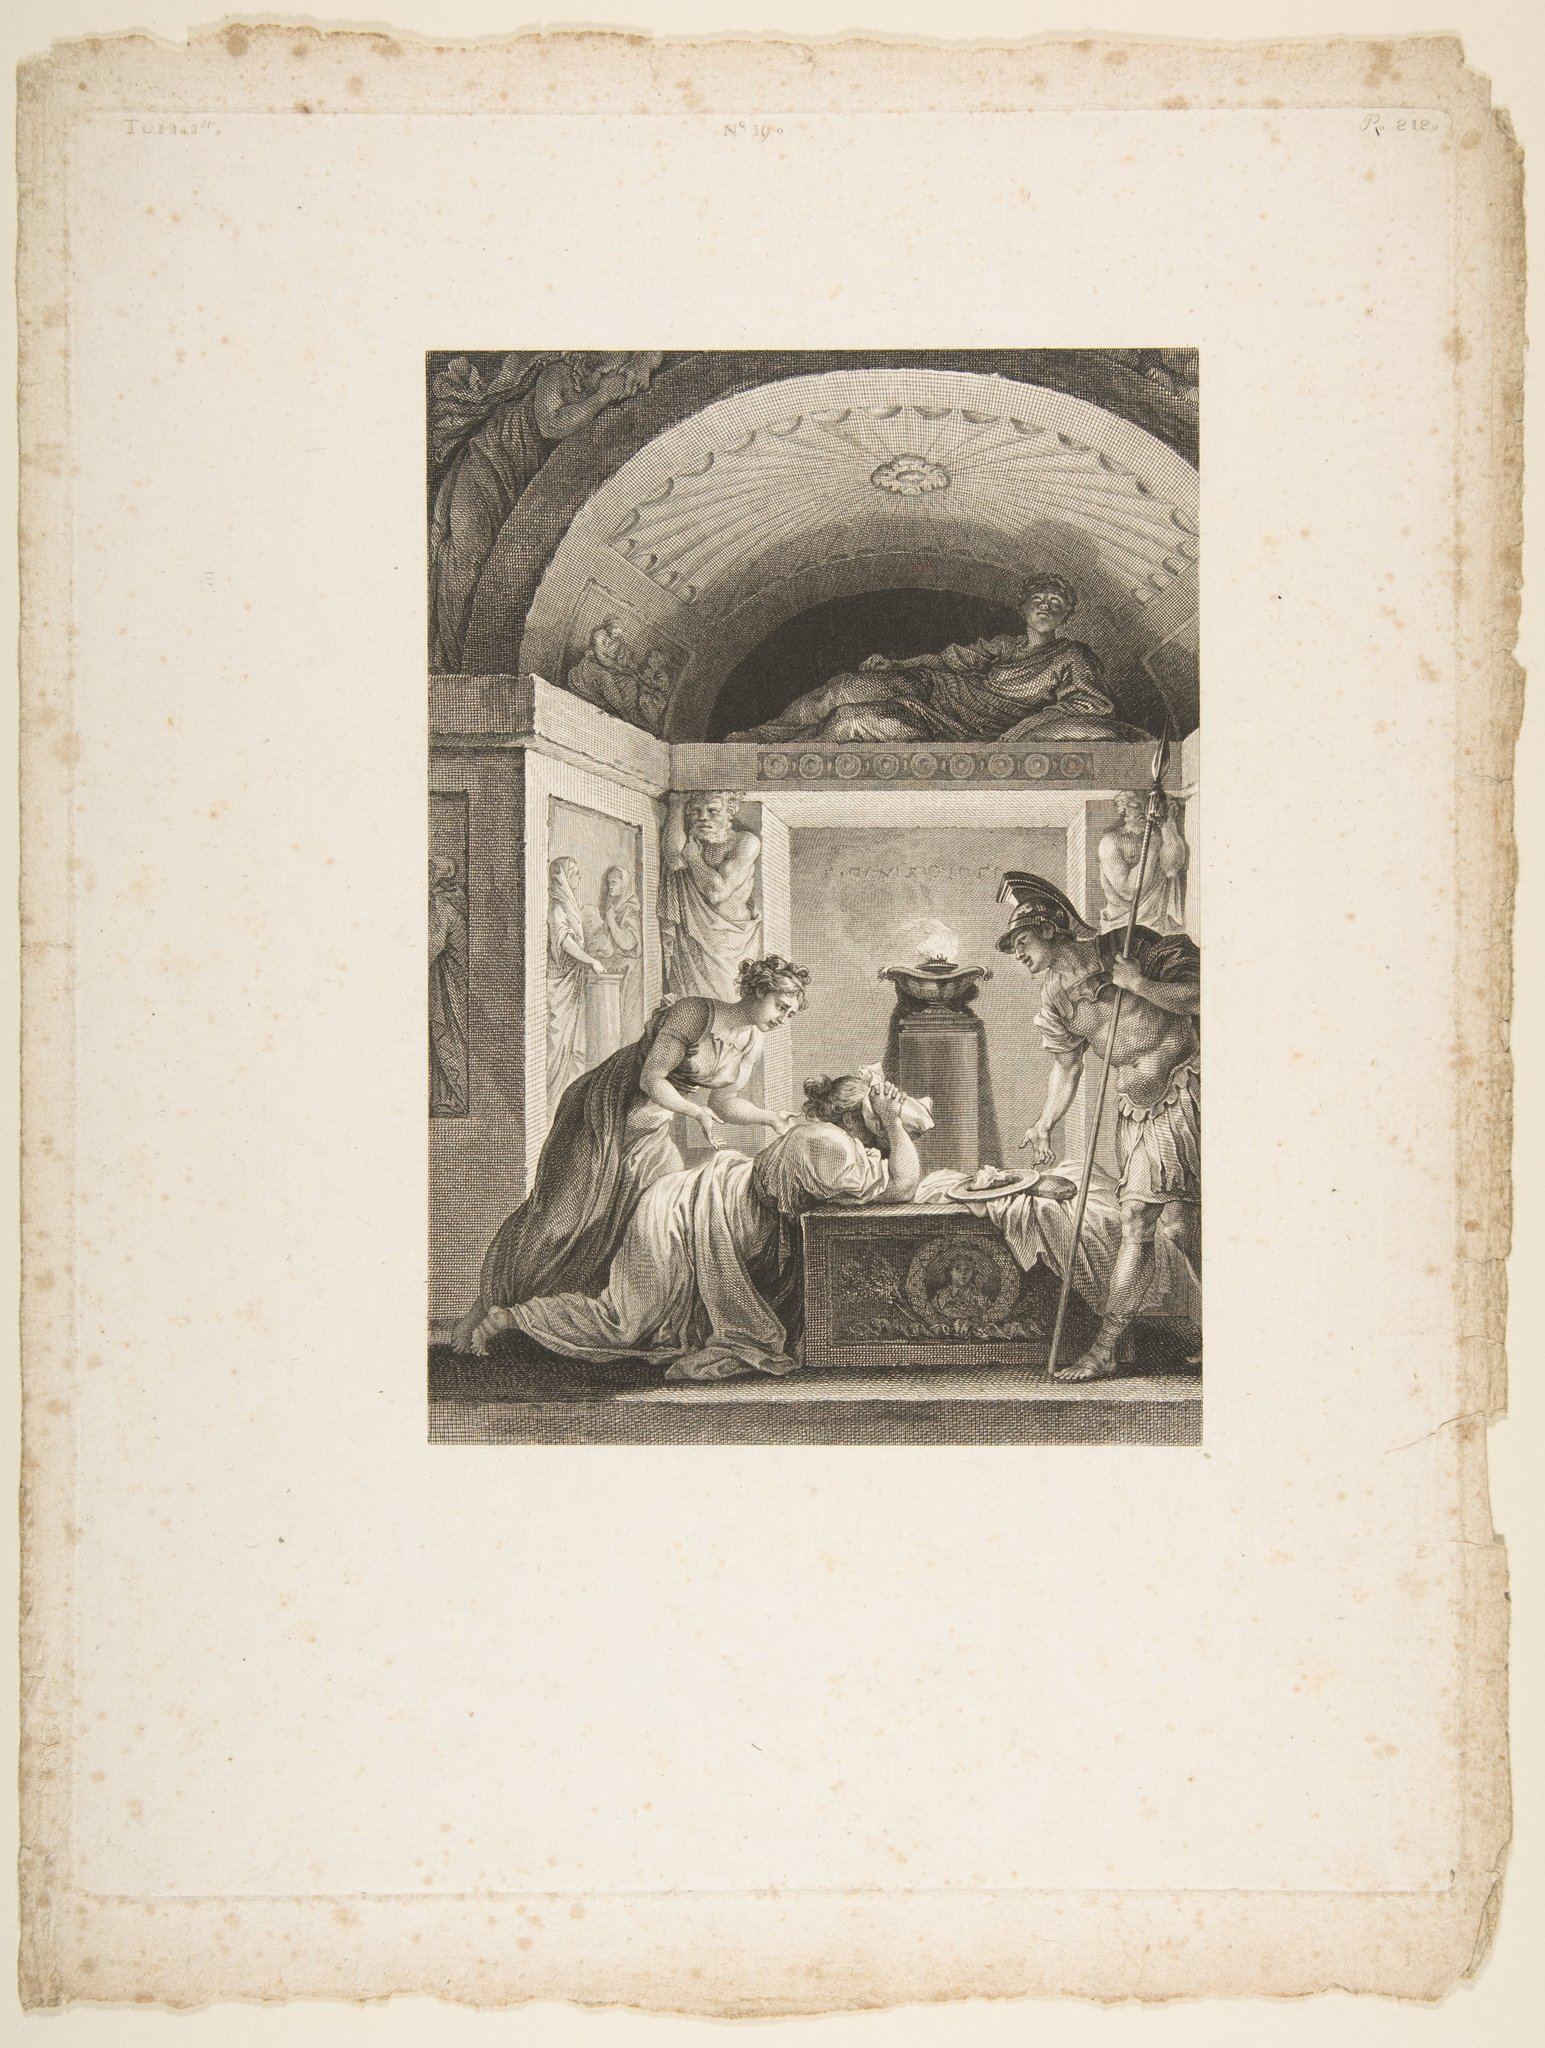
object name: print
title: La Matrone d'Ephese, from "Contes et nouvelles en vers par Jean de La Fontaine. A Paris, de l'imprimerie de P. Didot, l'an III de la République, 1795"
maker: jean-louis delignon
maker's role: artist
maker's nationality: french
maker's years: 1755-1804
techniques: engraving, etching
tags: sadness,men,women